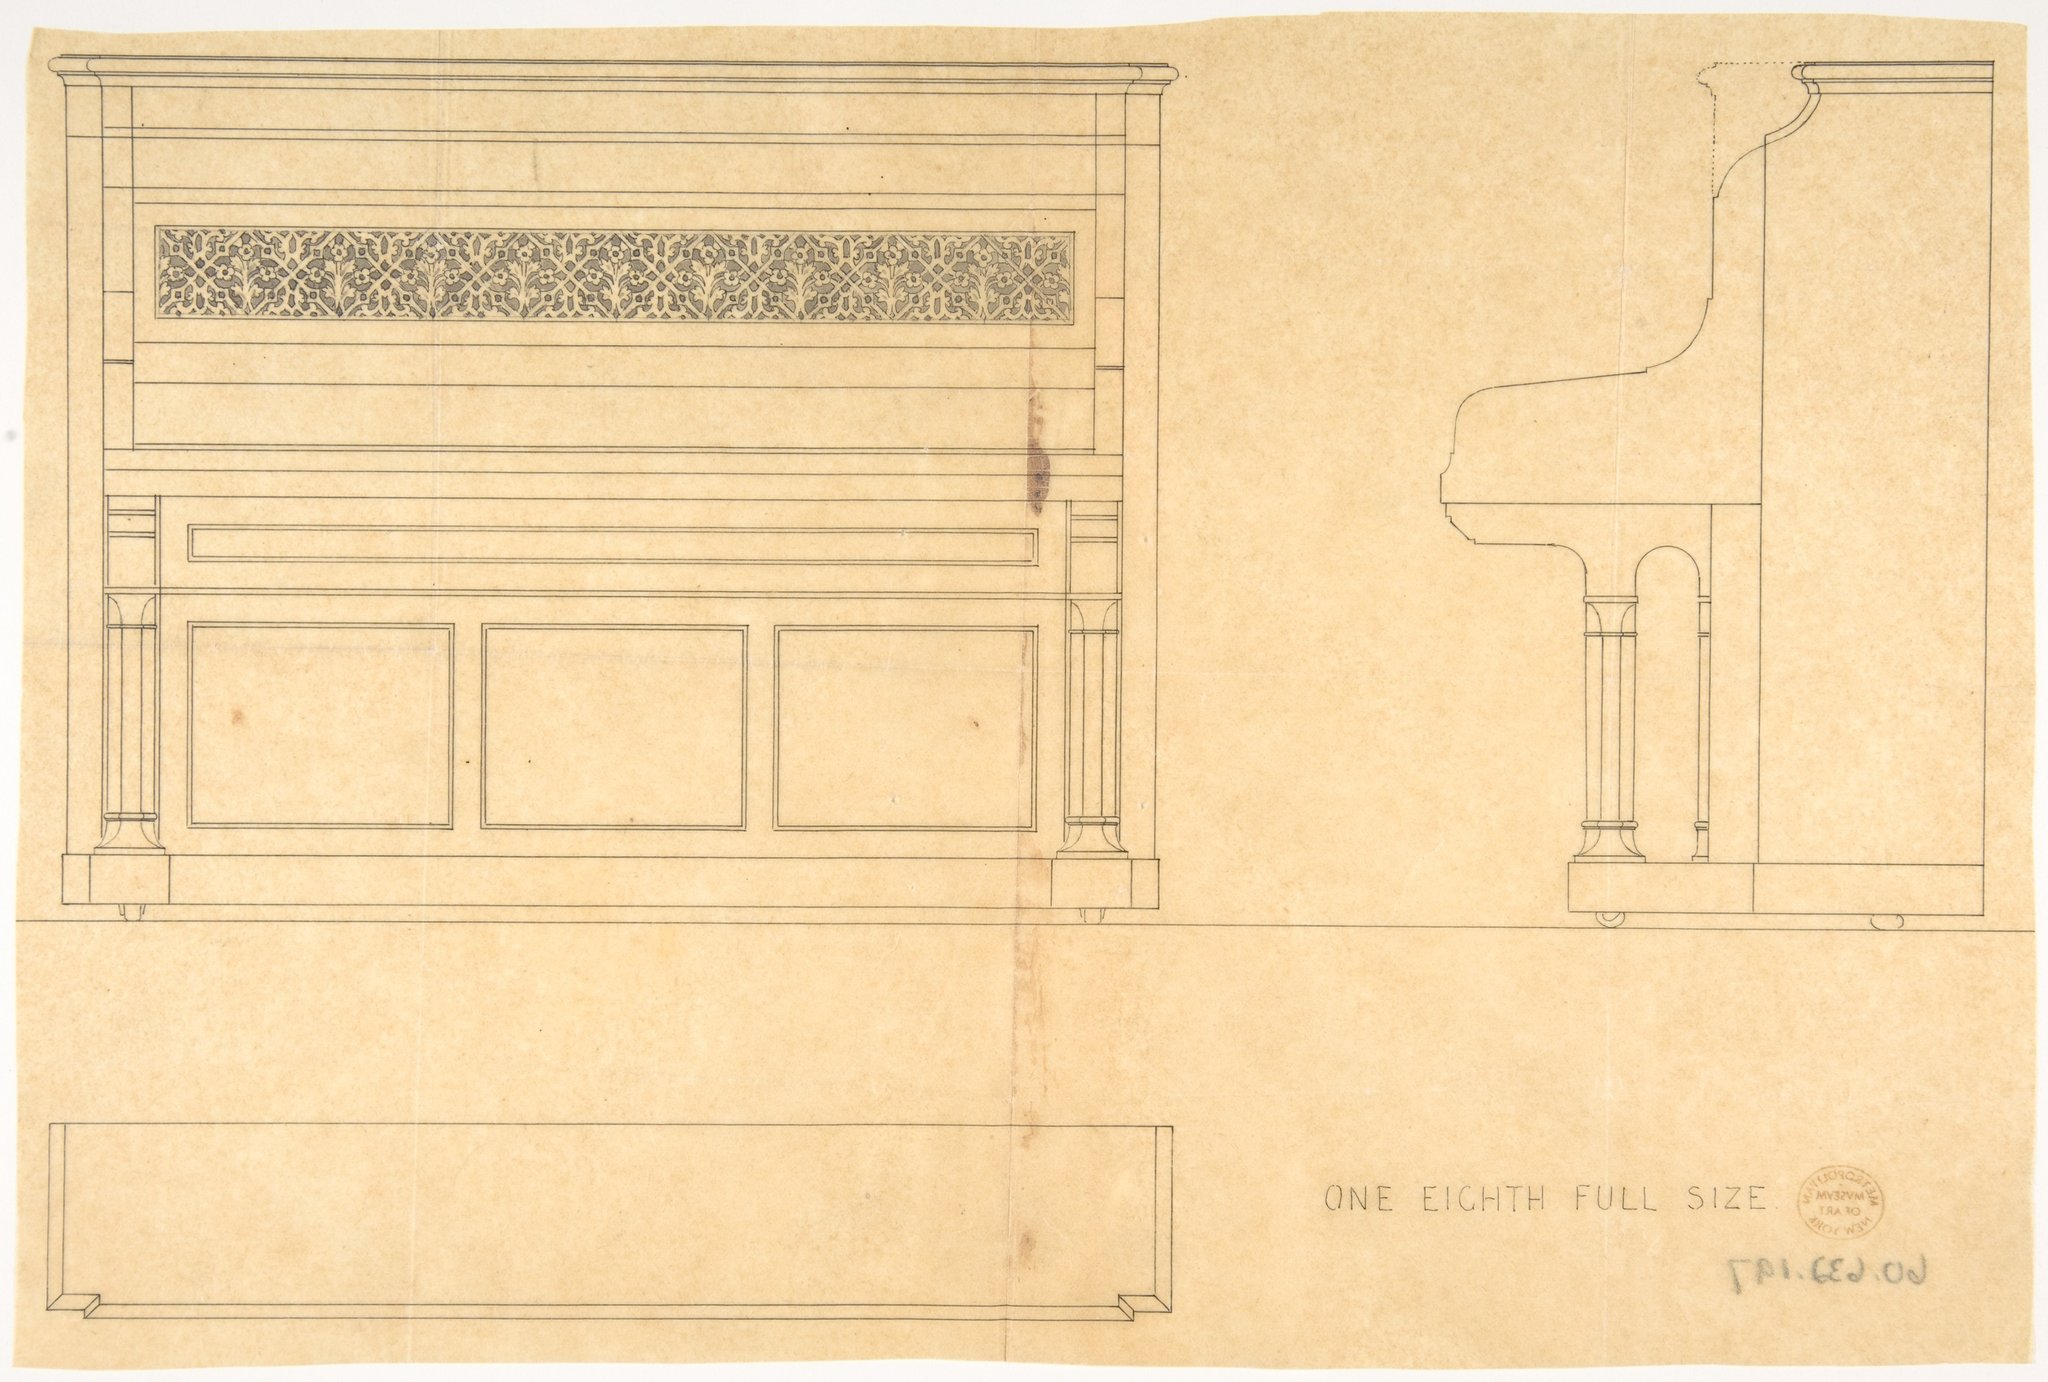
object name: drawing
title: Piano Design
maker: anonymous, british, 19th century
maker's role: artist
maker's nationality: british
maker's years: 1800-1900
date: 1801-1900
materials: ink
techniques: pen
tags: pianos